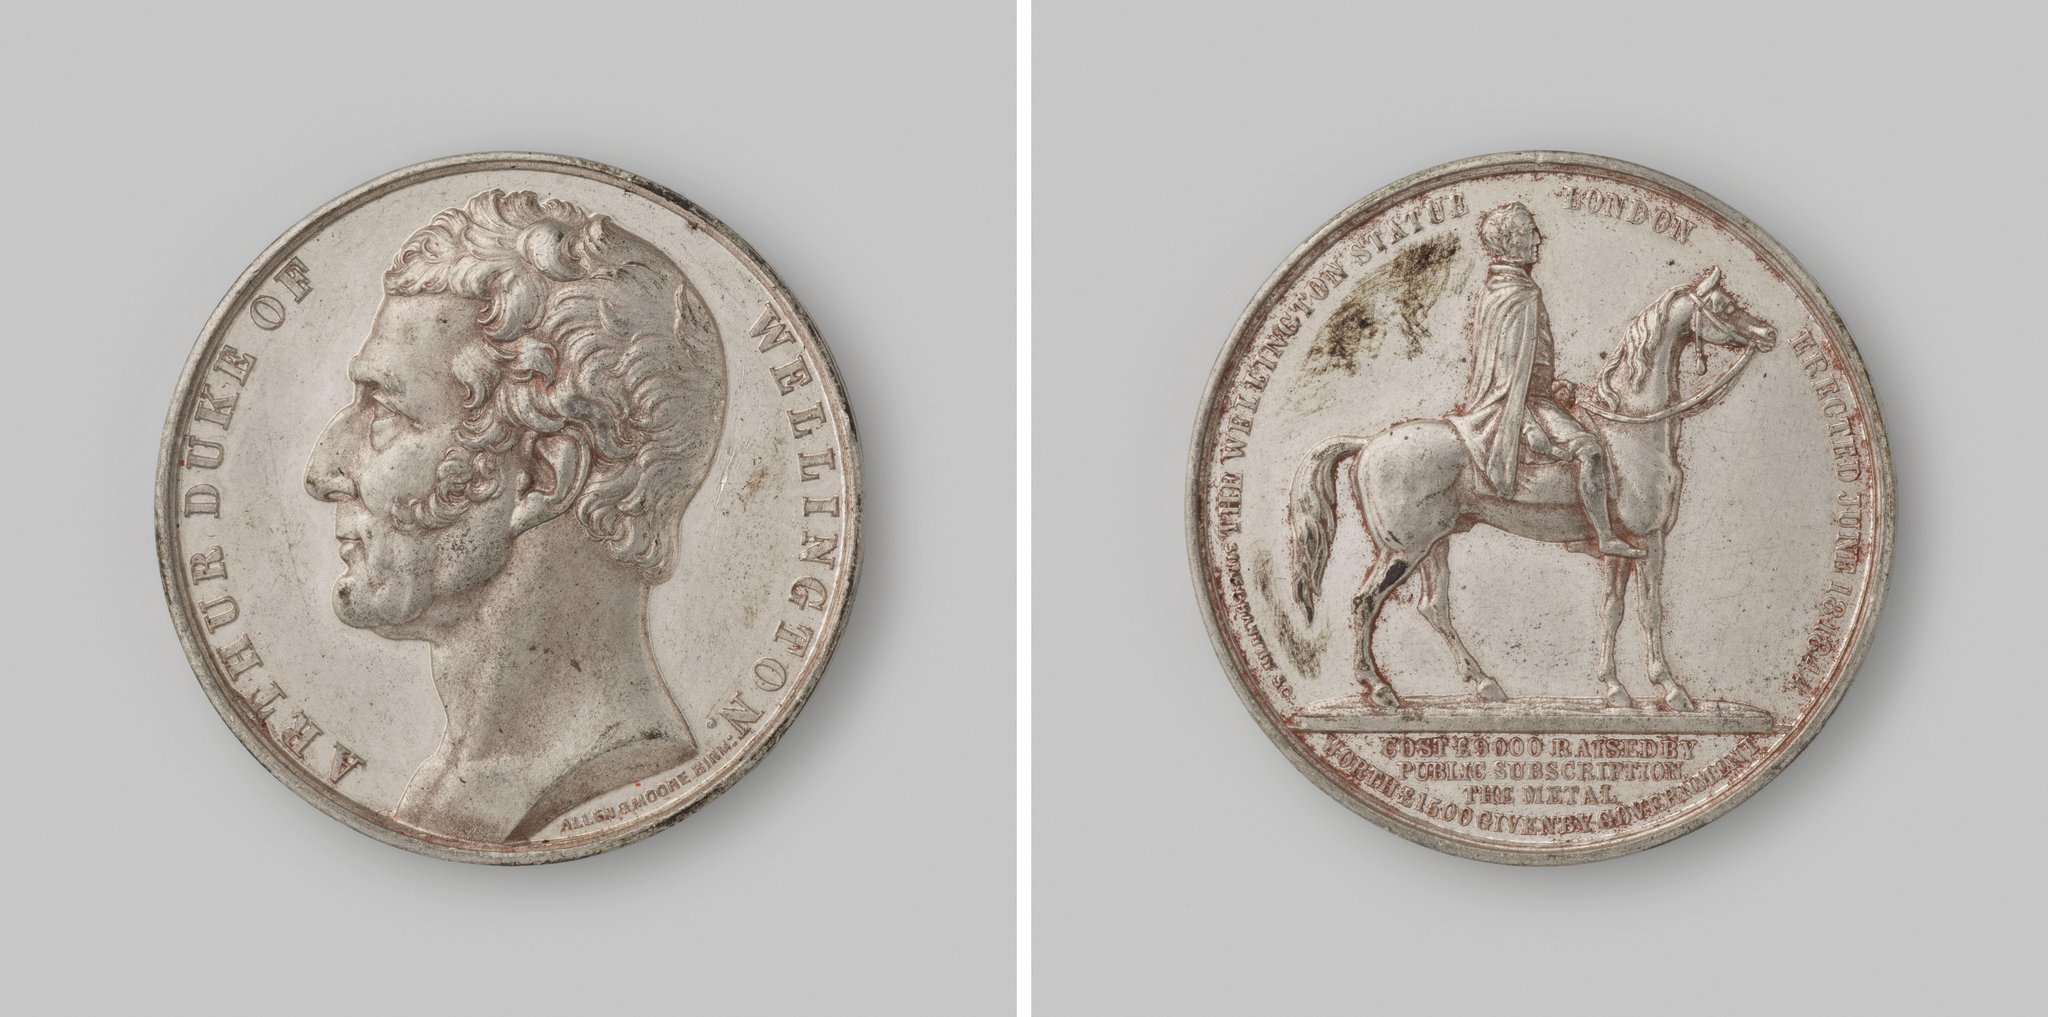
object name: history medal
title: Onthulling van het ruiterstandbeeld van Wellington te Londen 1844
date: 1844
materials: tin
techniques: striking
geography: birmingham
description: Tinnen penning, op de voorzijde het portret van Wellington naar links met omschrift, op de keerzijde het ruiterstandbeeld naar rechts met omschrift en afsnedetekst.